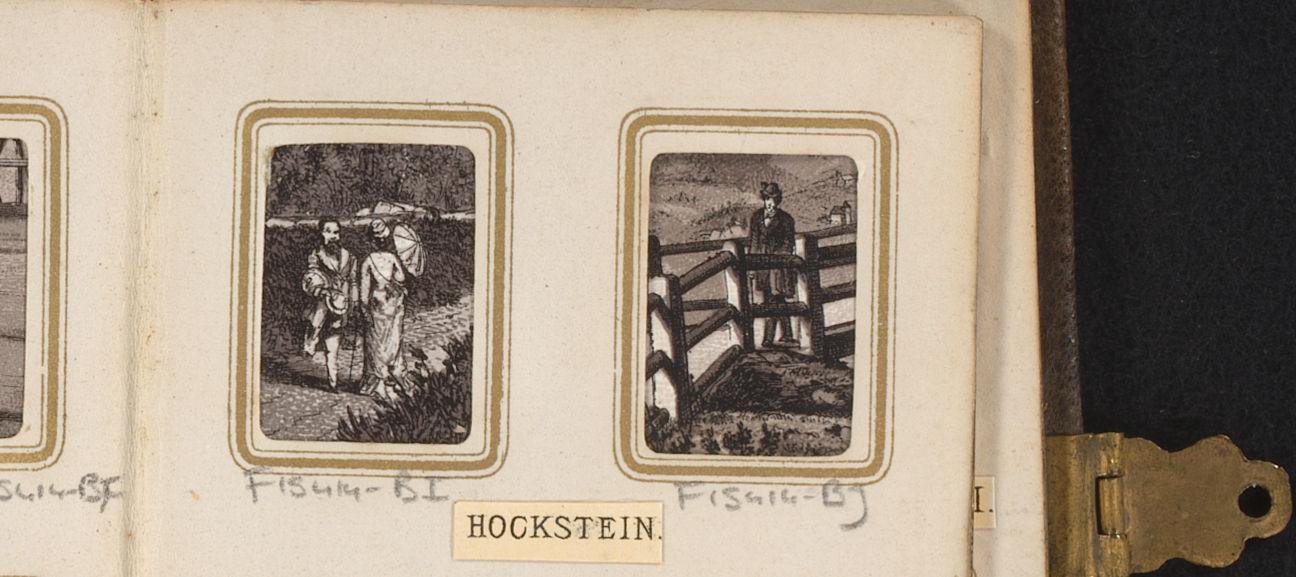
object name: print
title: Wandelaar op de Hochstein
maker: Anonymous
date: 1851-1910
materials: paper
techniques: lithograph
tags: walking, hiking (recreation)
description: Deze prent maakt deel uit van een album.